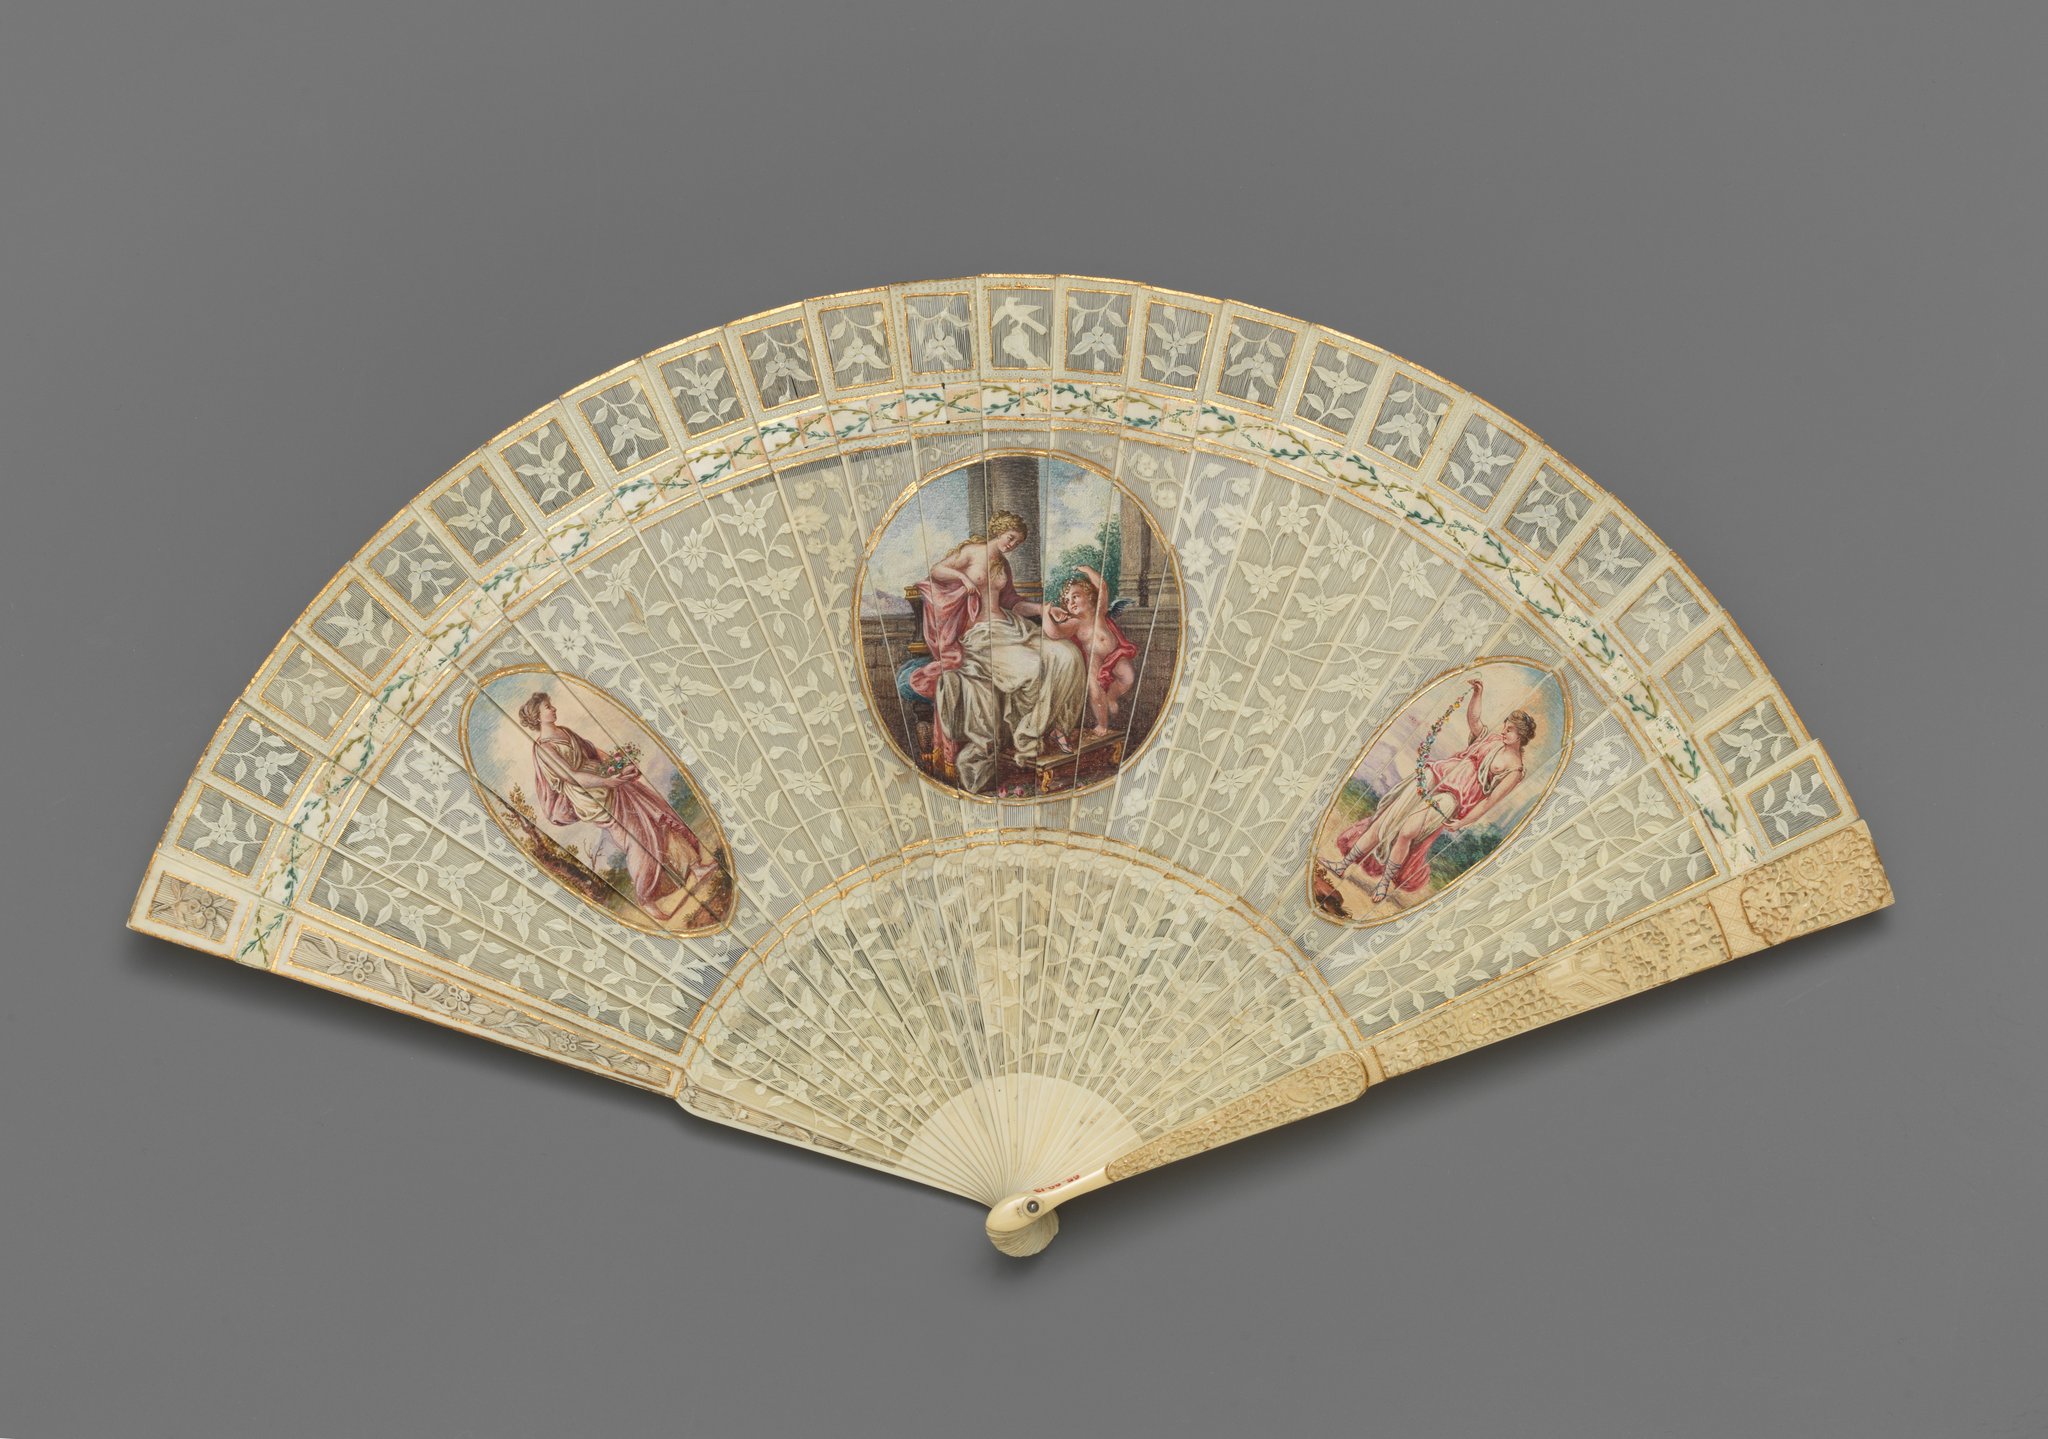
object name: fan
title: Brisé fan, with representations of classical figures flanking Venus and Cupid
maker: angelica kauffmann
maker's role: artist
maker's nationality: swiss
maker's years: 1741-1807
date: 1795-1800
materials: ivory, metal, paper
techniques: carving, gilding, painting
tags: women,female nudes,cupid,venus